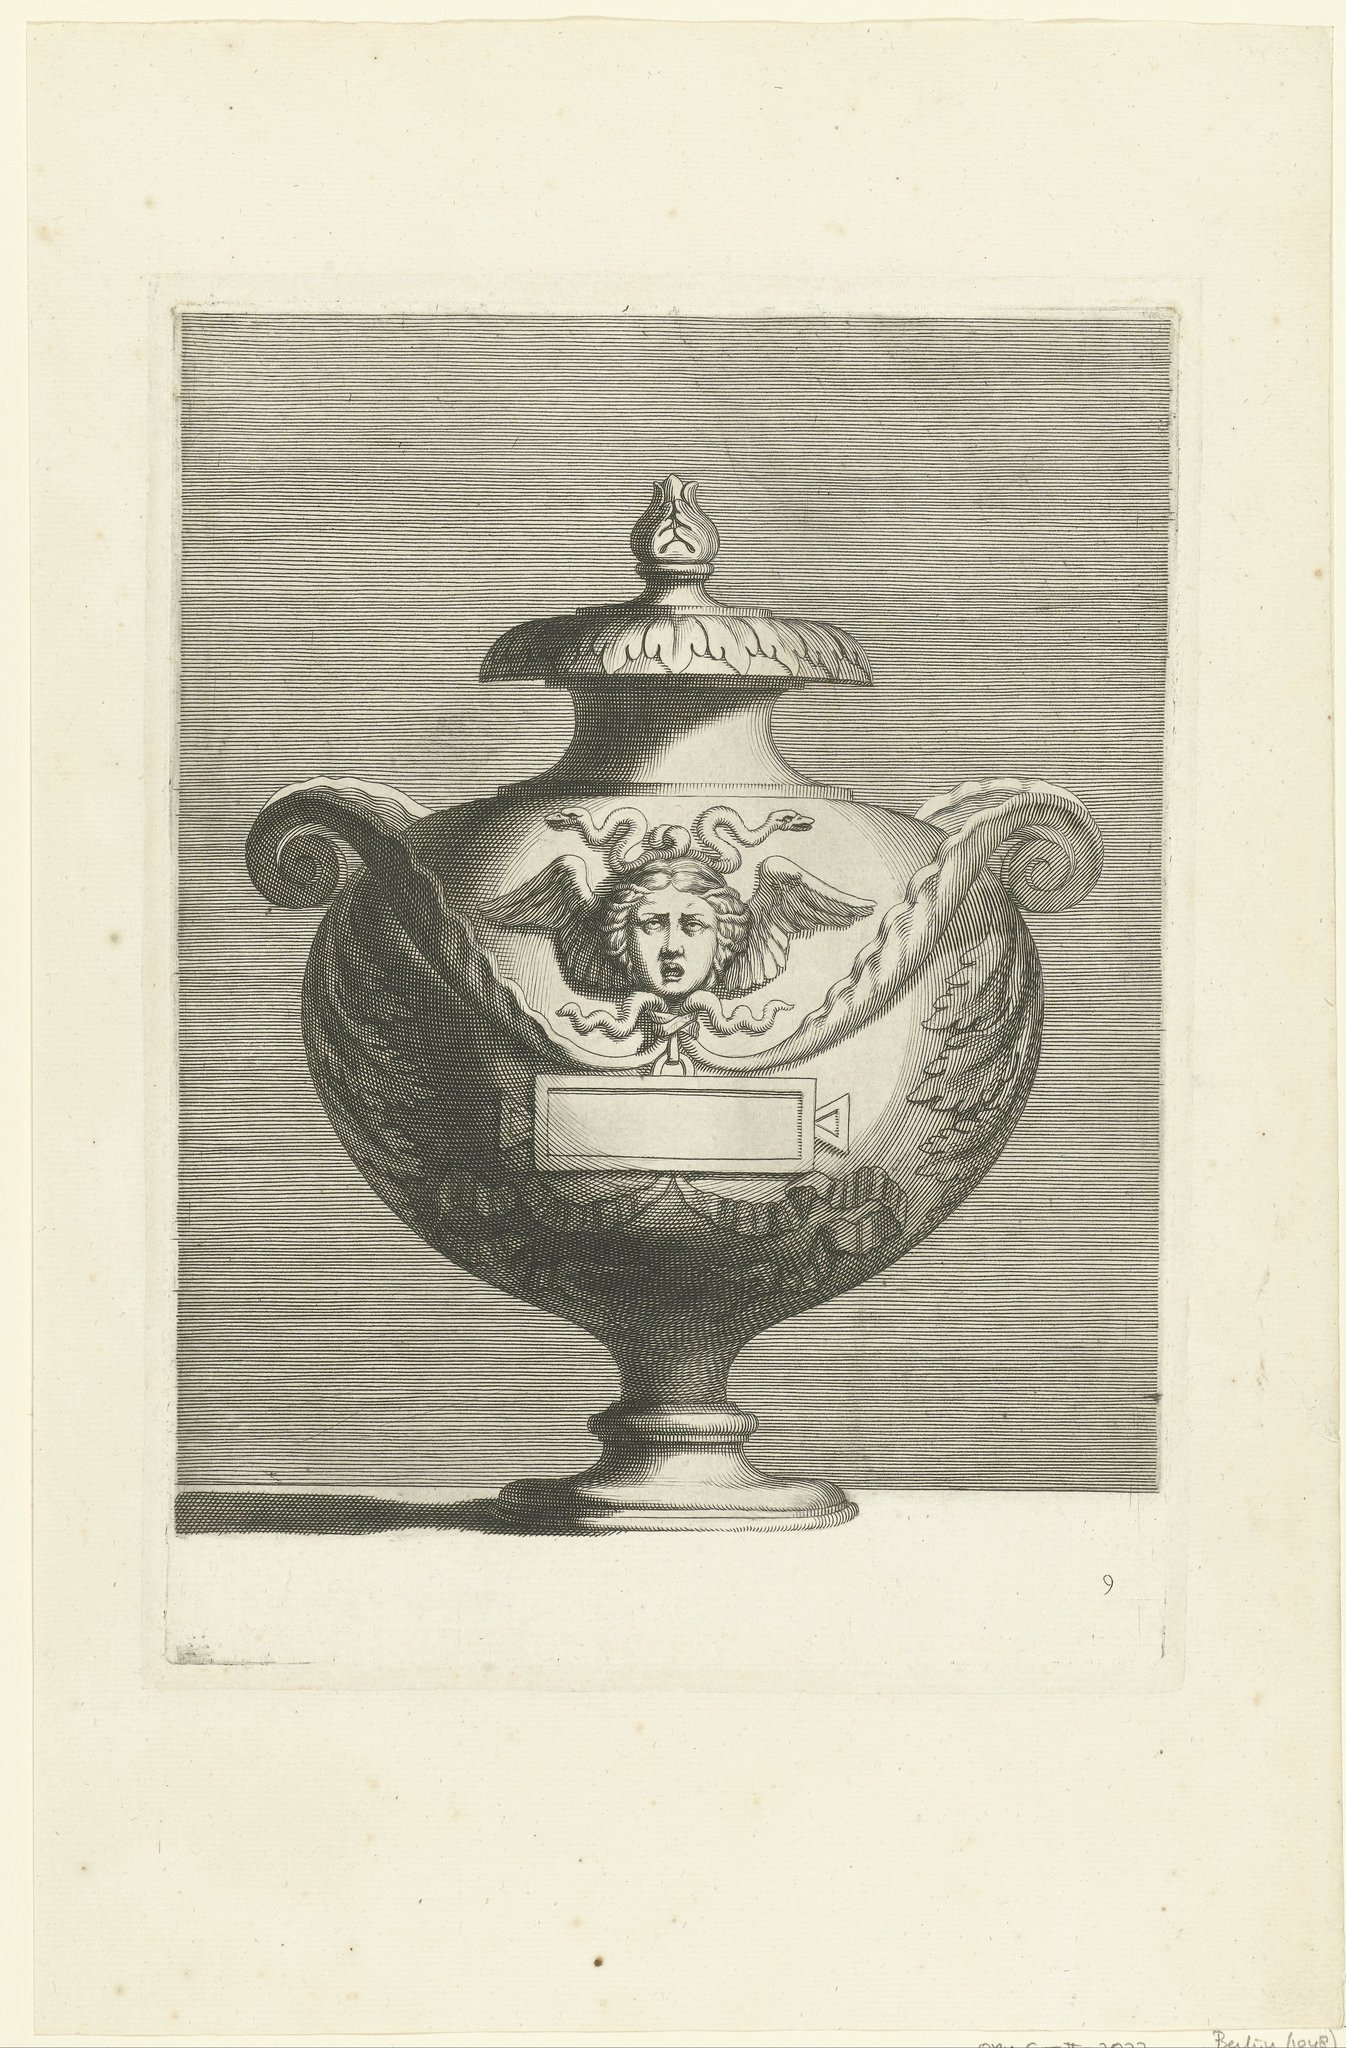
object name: ornament print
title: Livre de Vases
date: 1657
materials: paper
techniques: engraving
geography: france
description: Aan de handvatten, in de vorm van geribbelde consoles, hangt een tablet met daarboven het hoofd van Medusa. Blad 9 uit serie van 24 bladen, genummerd: 1-21, 23-25.